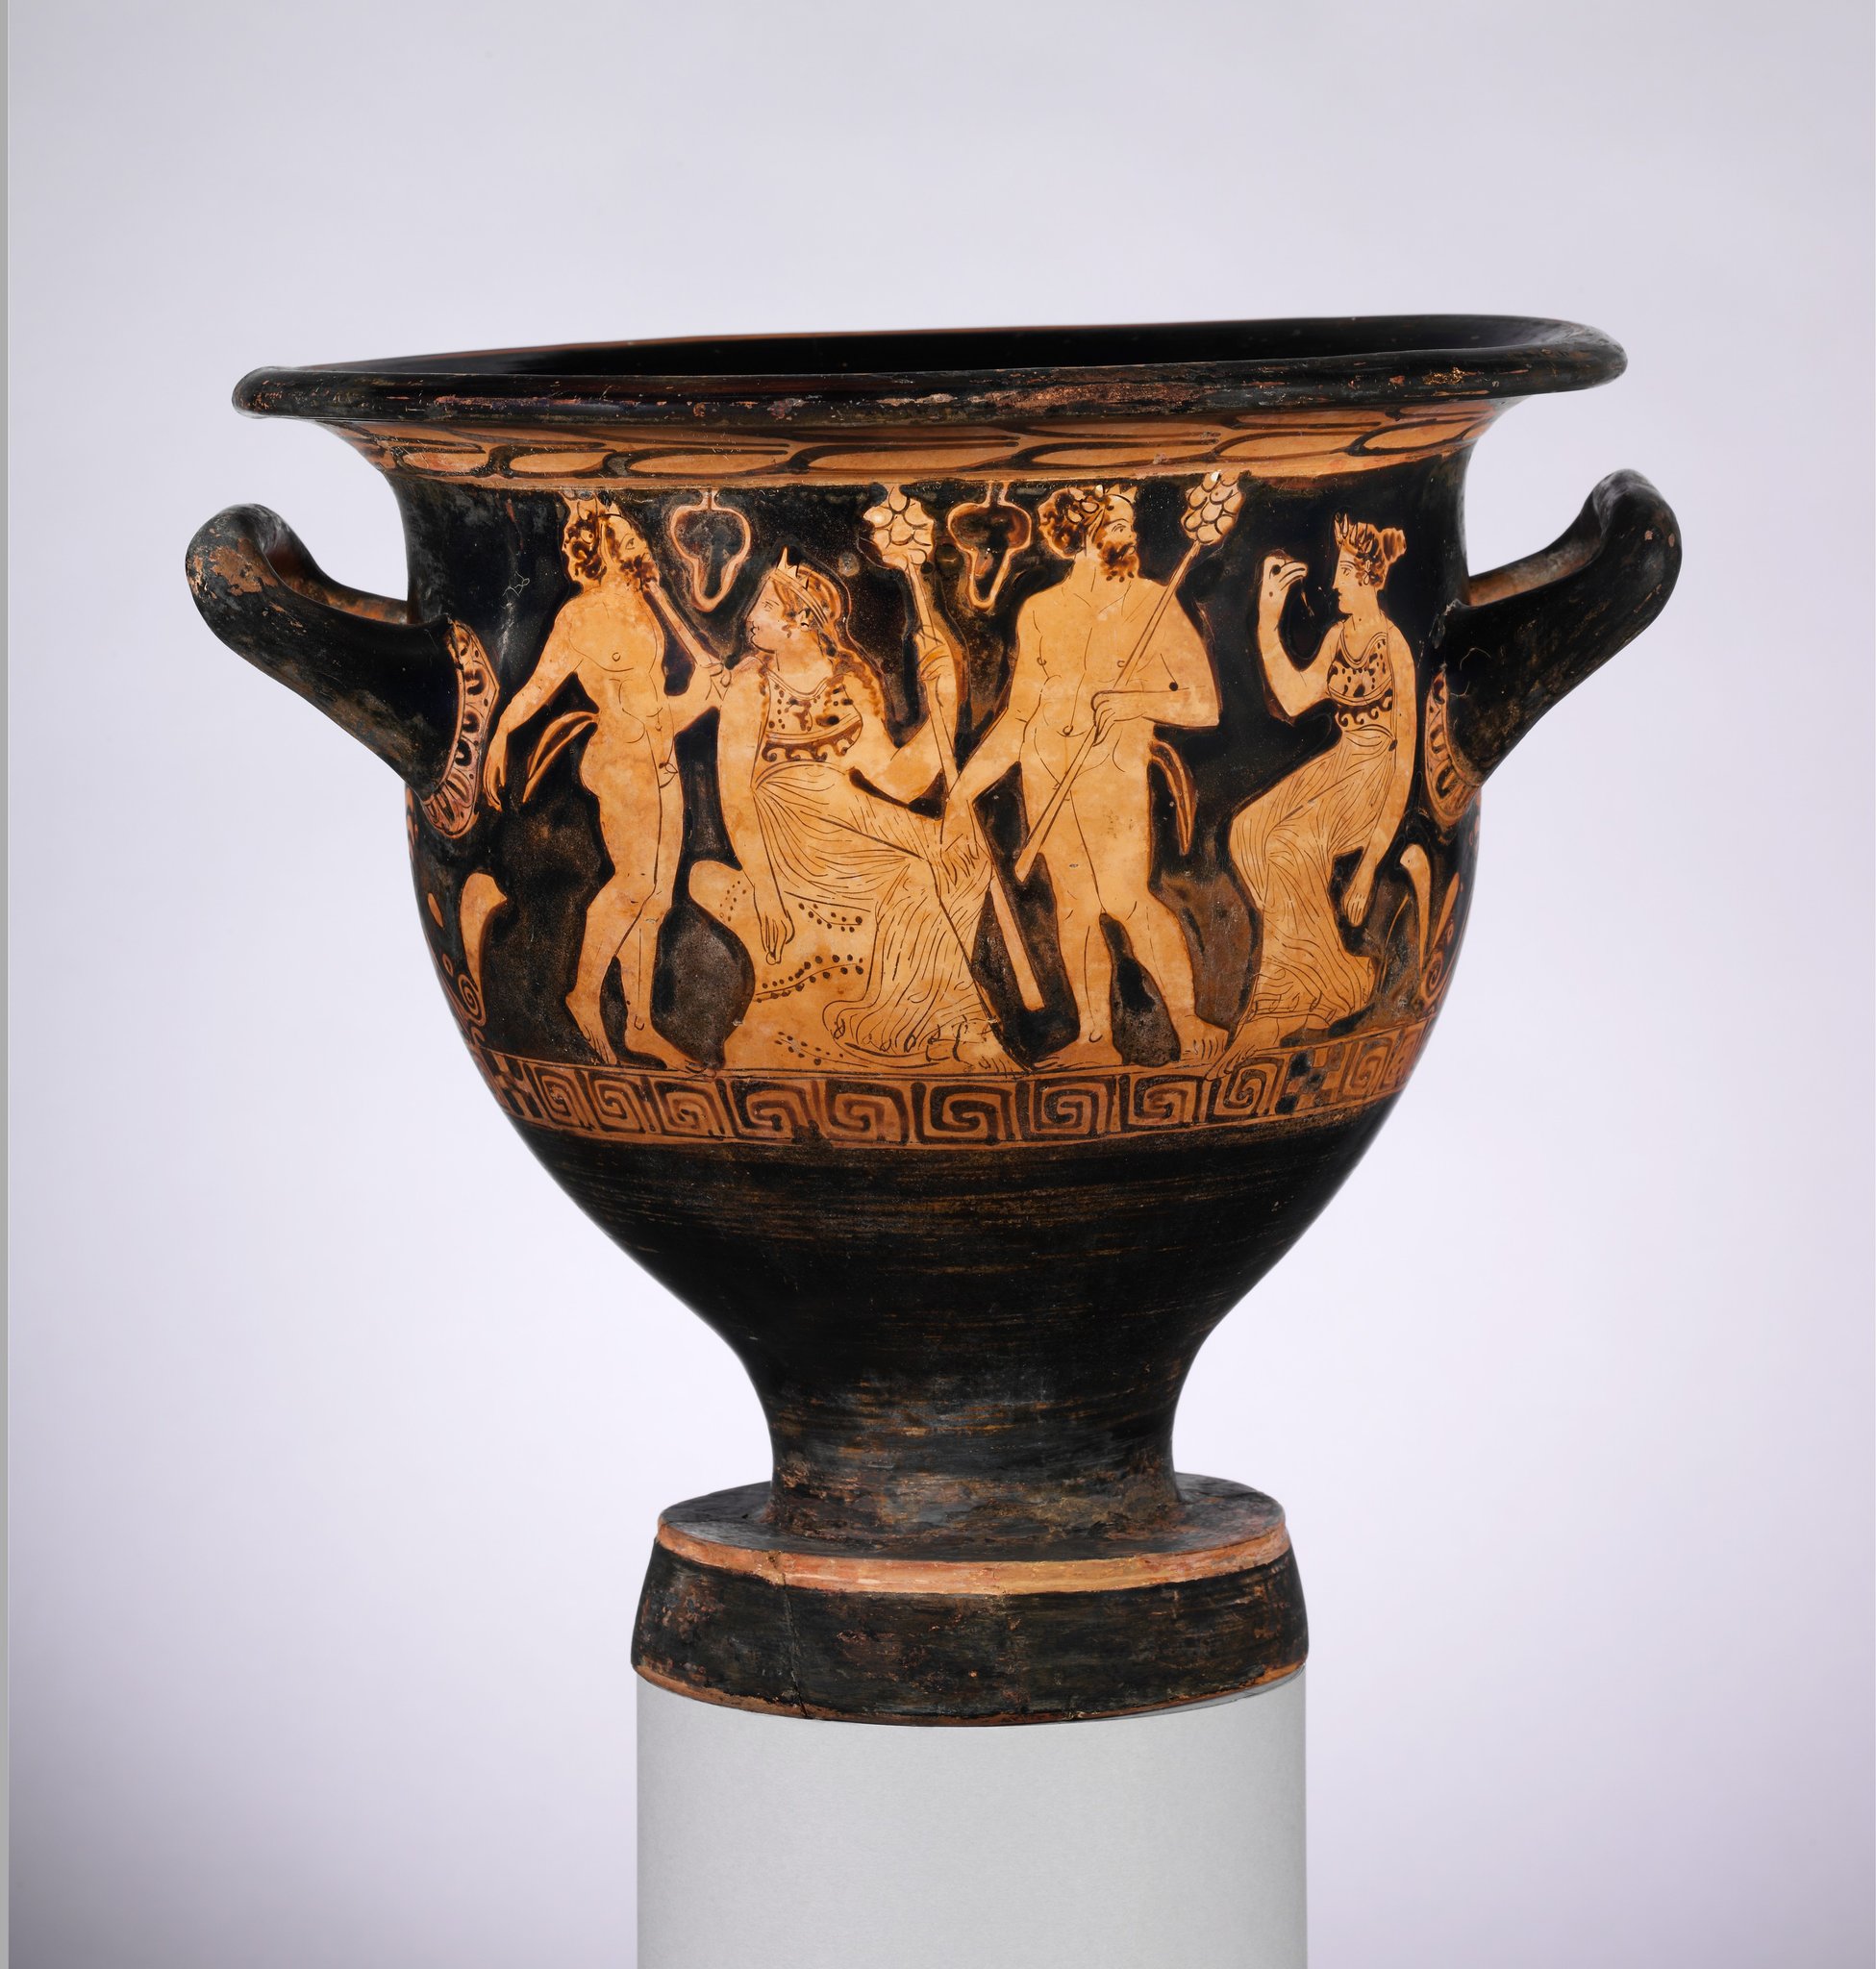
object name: bell krater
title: Terracotta bell-krater (vase for mixing wine and water)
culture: greek, attic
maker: meleager painter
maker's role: artist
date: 390-380 BCE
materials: terracotta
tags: men,maenads,satyrs